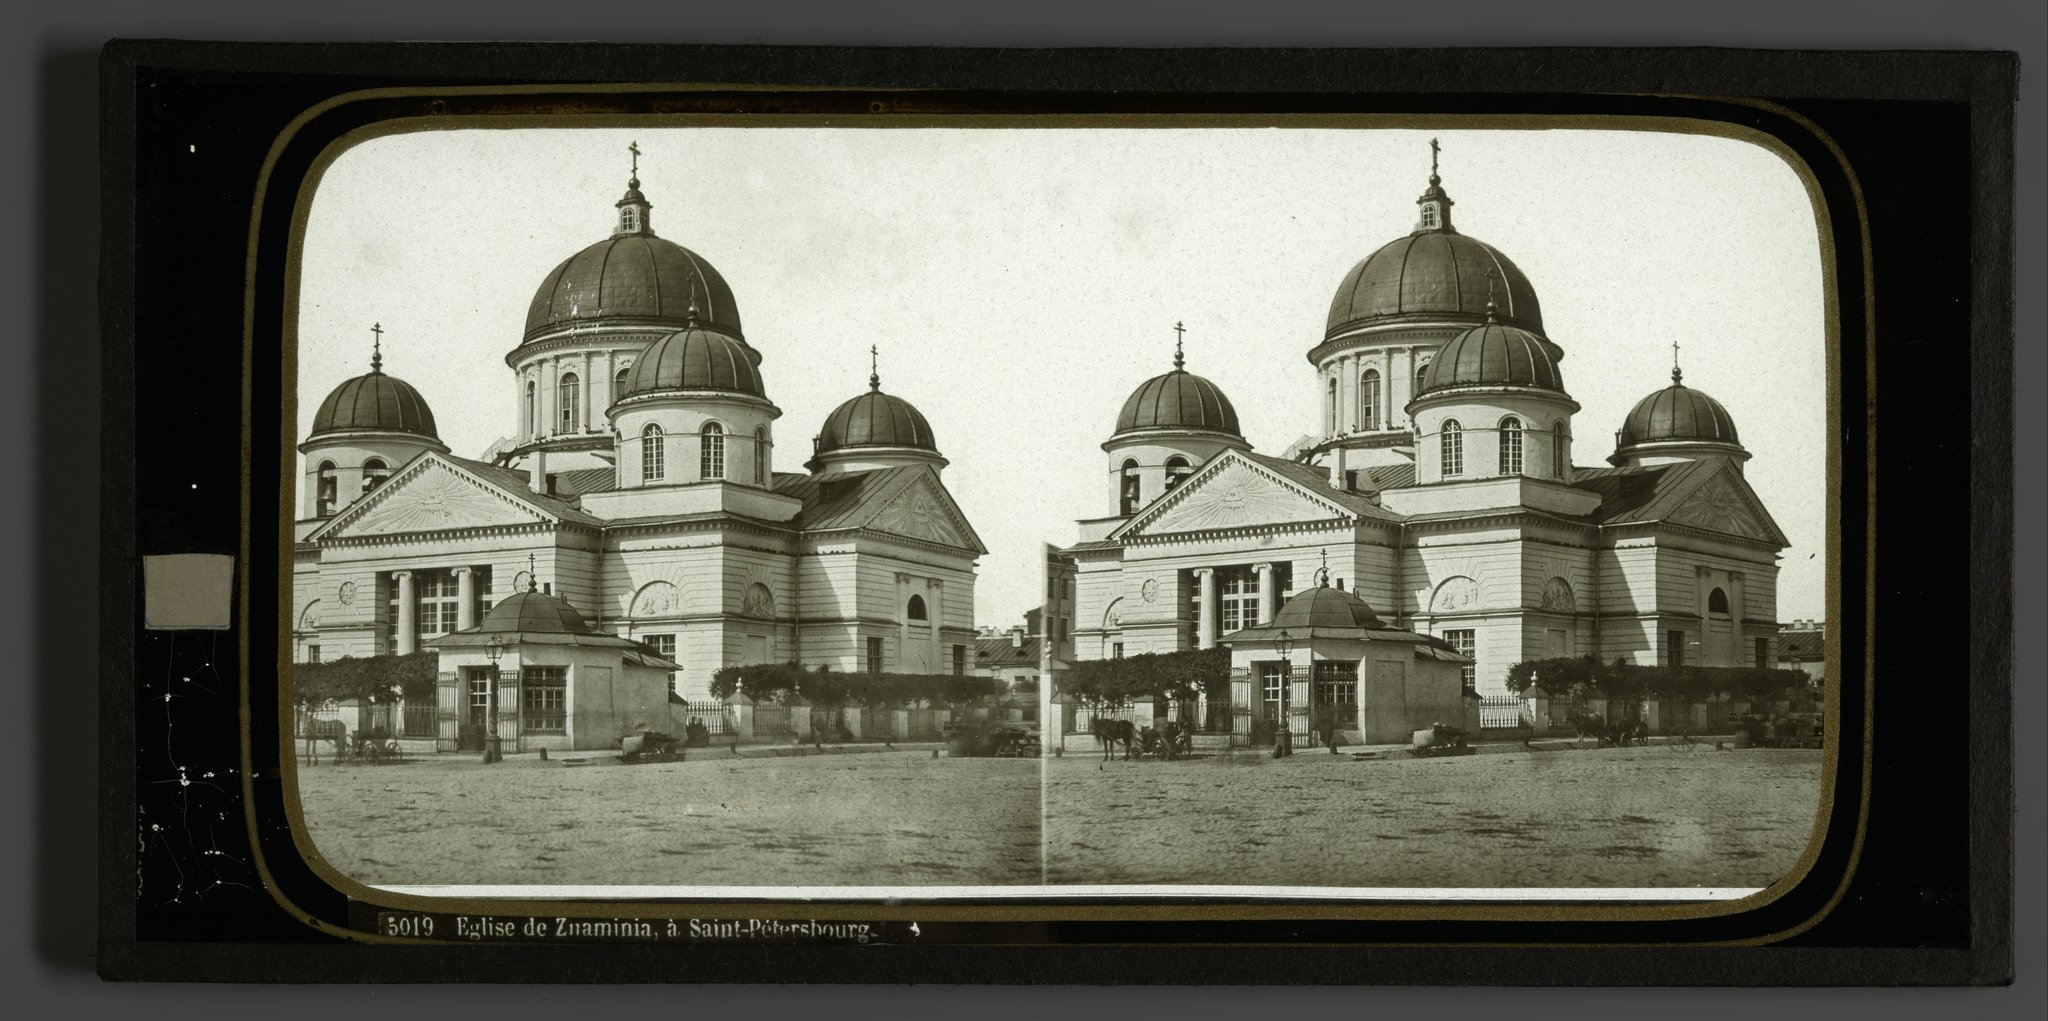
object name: photograph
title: Gezicht op een kerk in Sint-Petersburg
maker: Anonymous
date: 1860-1890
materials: glass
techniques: slide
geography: sint-petersburg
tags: russian orthodox church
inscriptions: number: ‘5019’